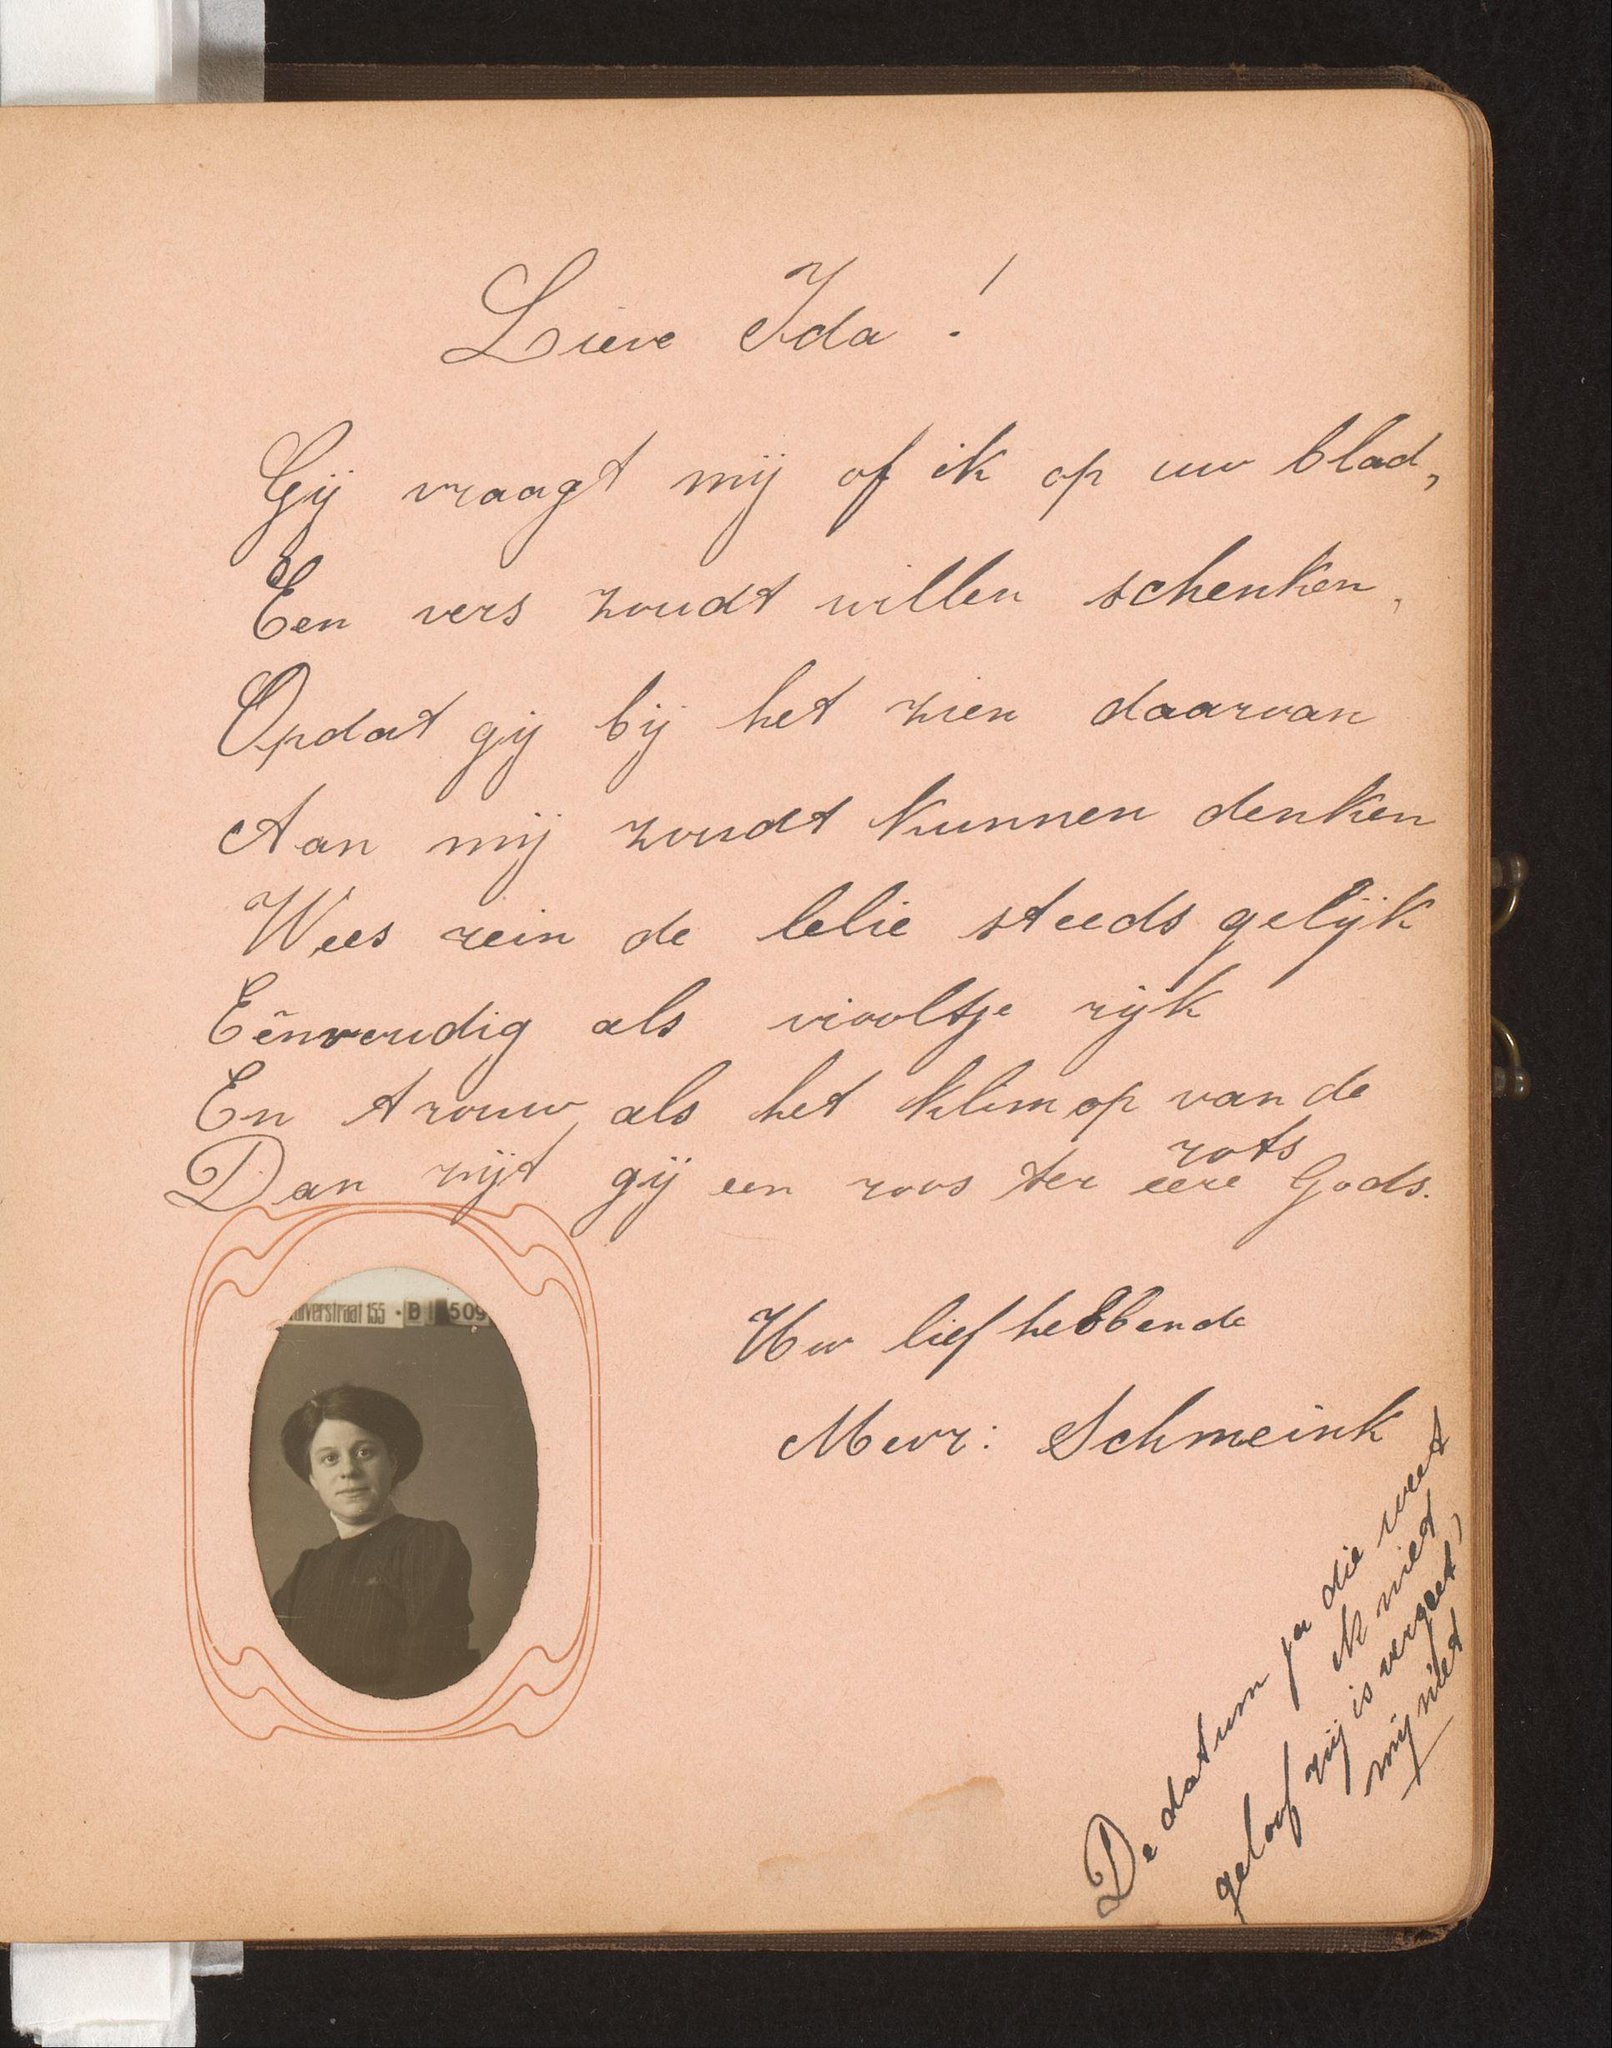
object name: album leaf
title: Portret van mevrouw Schmeink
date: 1900-1930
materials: photographic support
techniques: gelatin silver print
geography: amsterdam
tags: adult woman, historical persons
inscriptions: annotation: ‘Lieve Ida/ (...)’